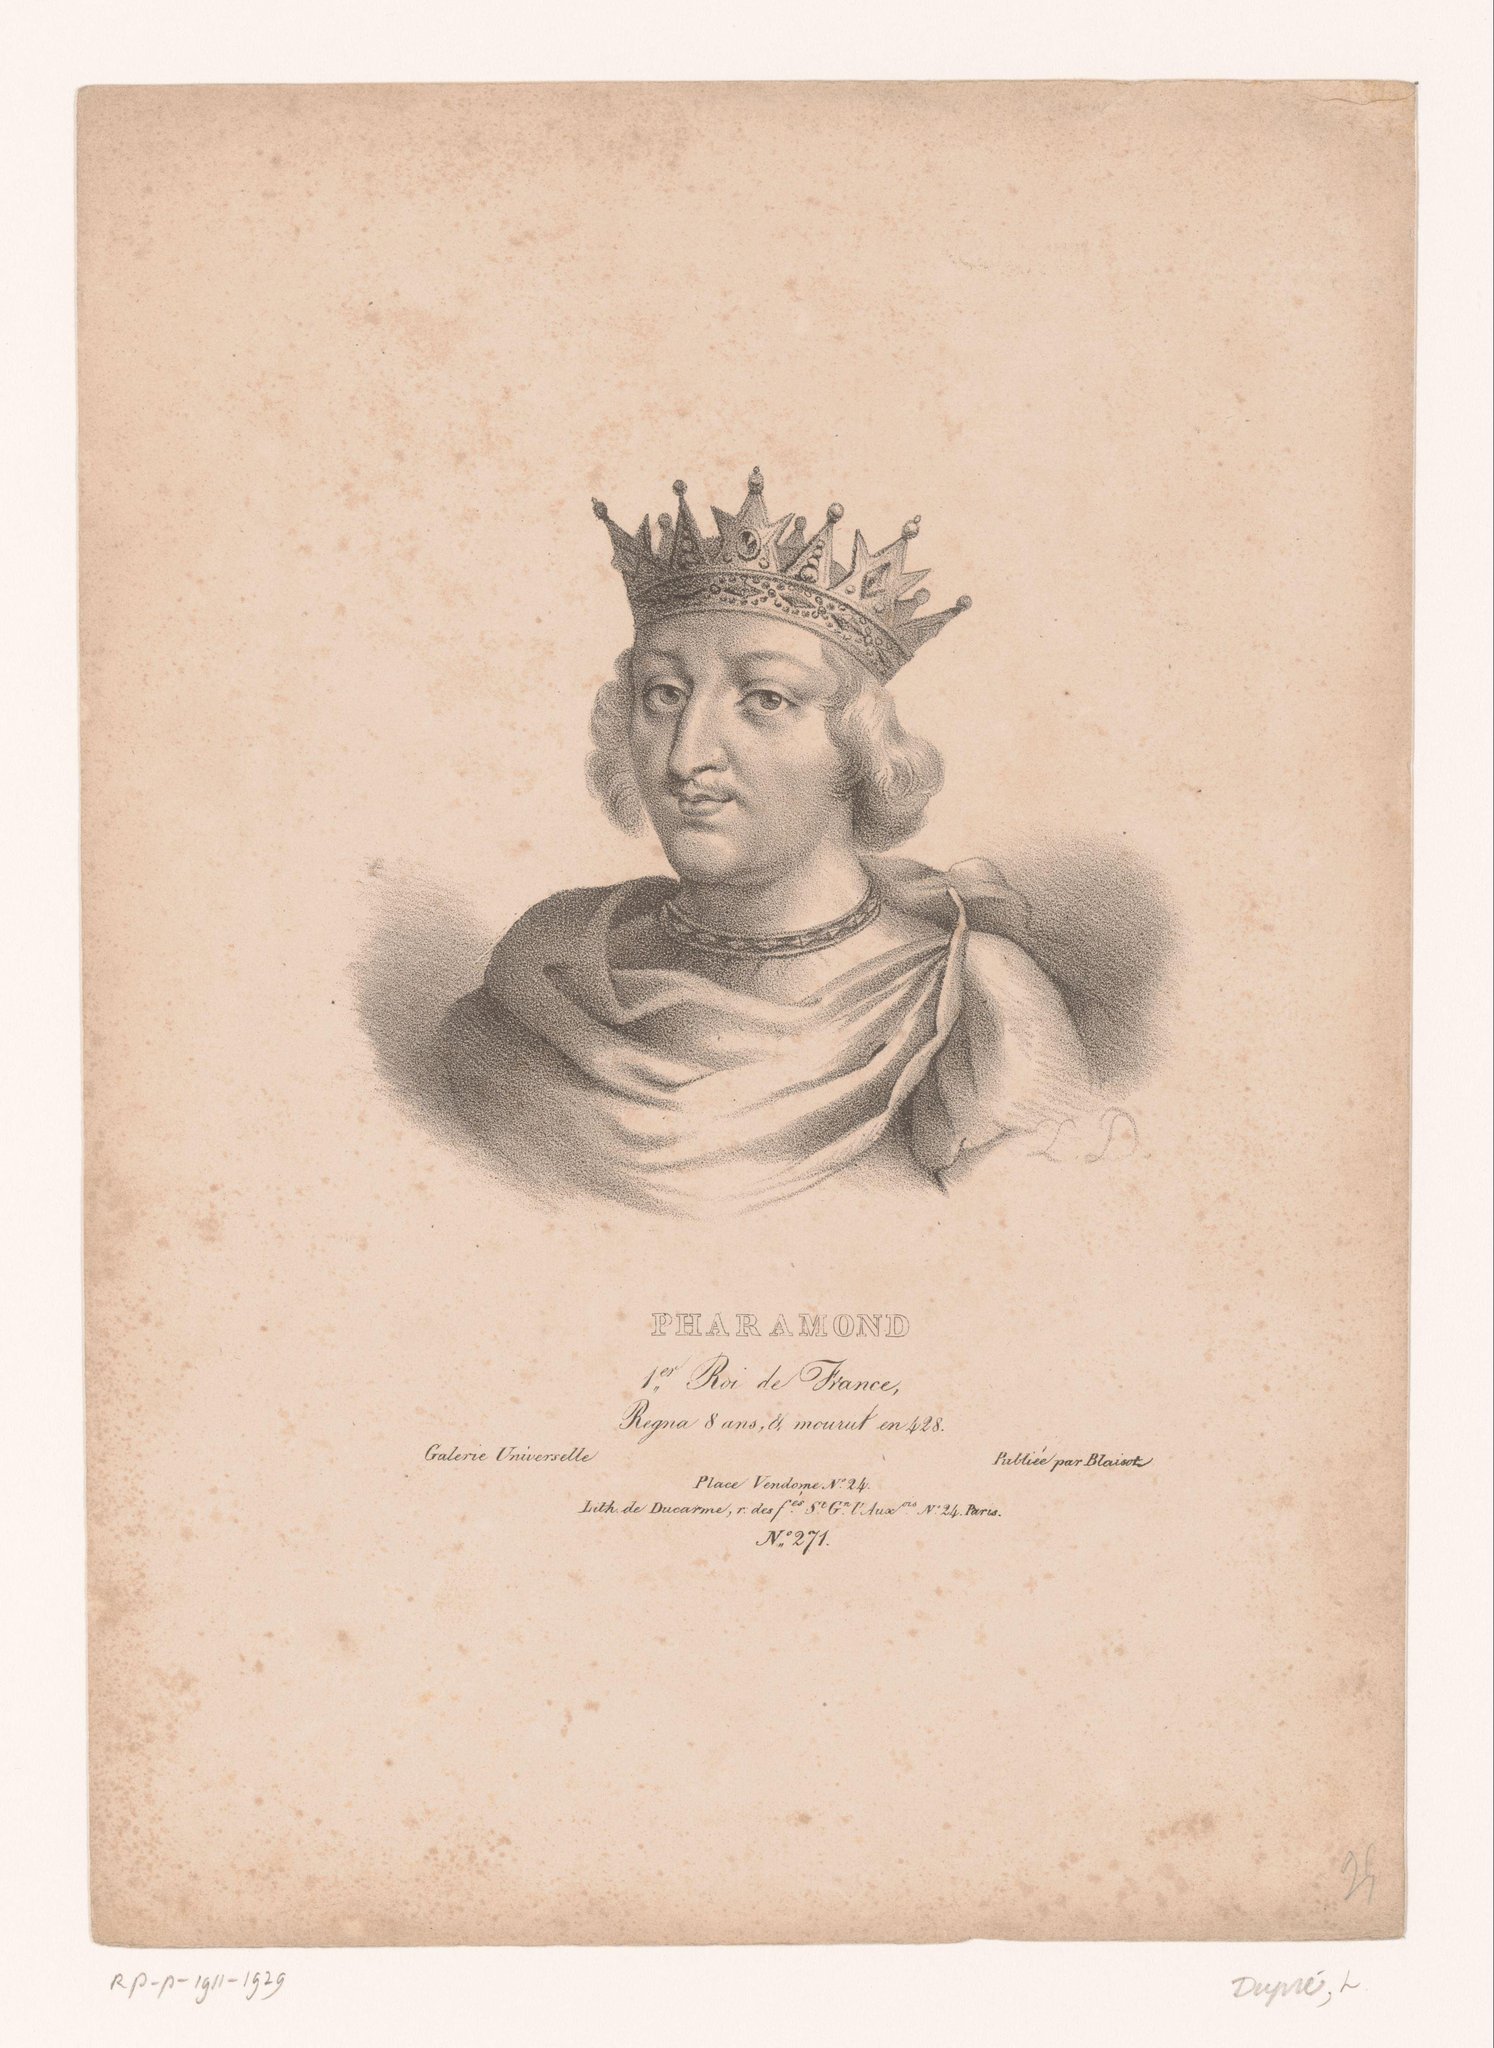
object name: print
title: Portret van koning Pharamond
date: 1820-1829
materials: paper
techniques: lithograph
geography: paris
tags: historical persons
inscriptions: collector's mark: Lugt 2228a